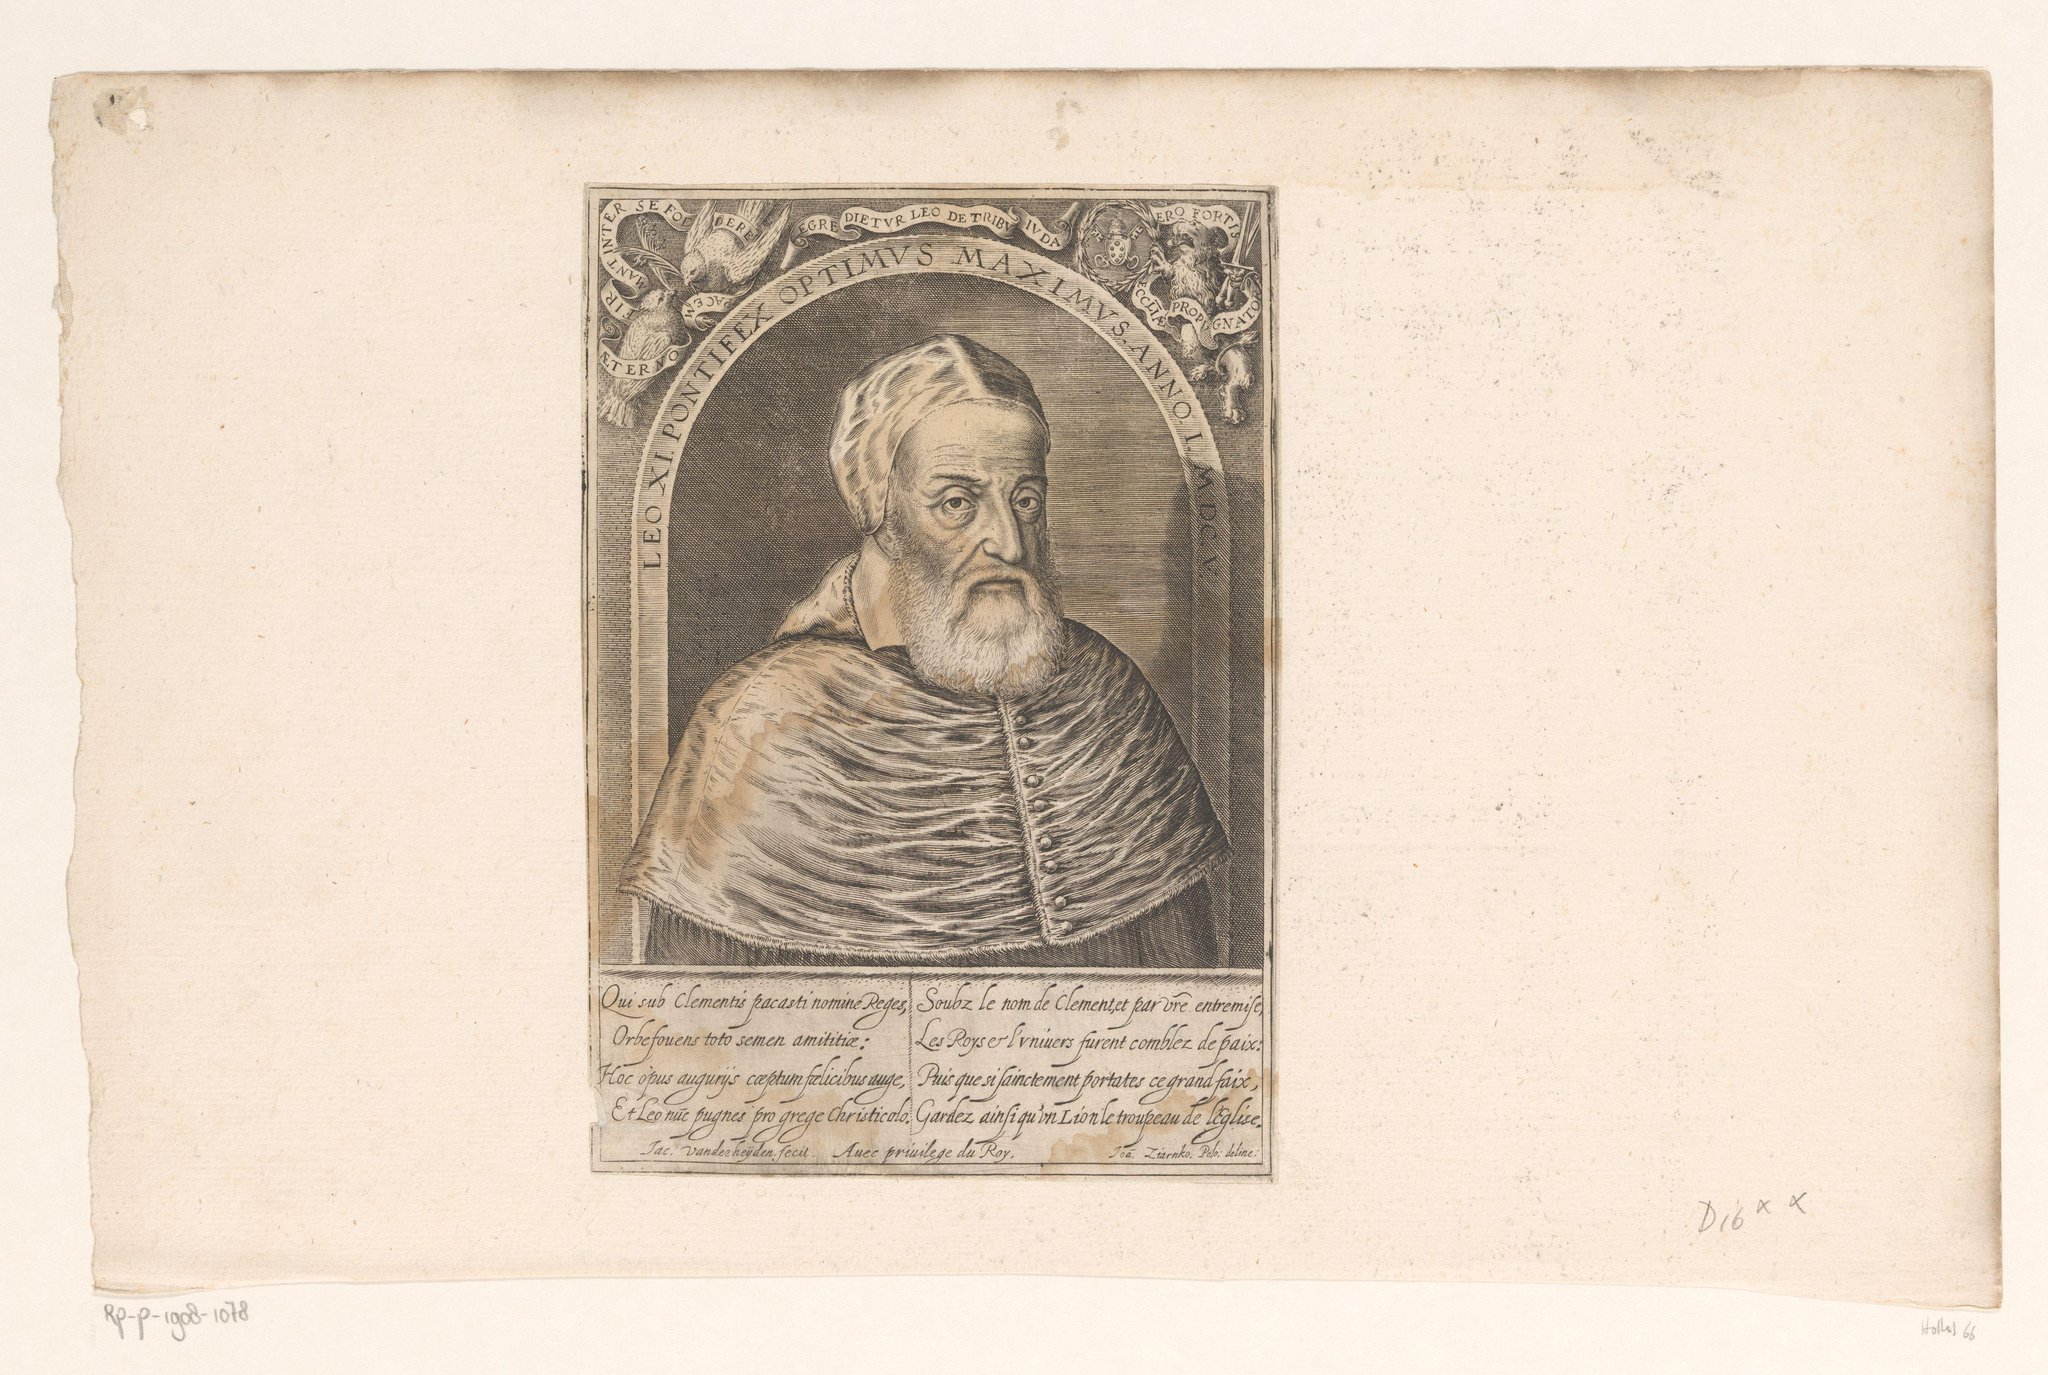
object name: print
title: Portret van paus Leo XI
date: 1605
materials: paper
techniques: engraving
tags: leo xi, other birds: dove, historical persons, beasts of prey, predatory animals: lion, pope, armorial bearing, heraldry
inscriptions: collector's mark: Lugt 2228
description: Met onderschrift in het Latijn en Frans.